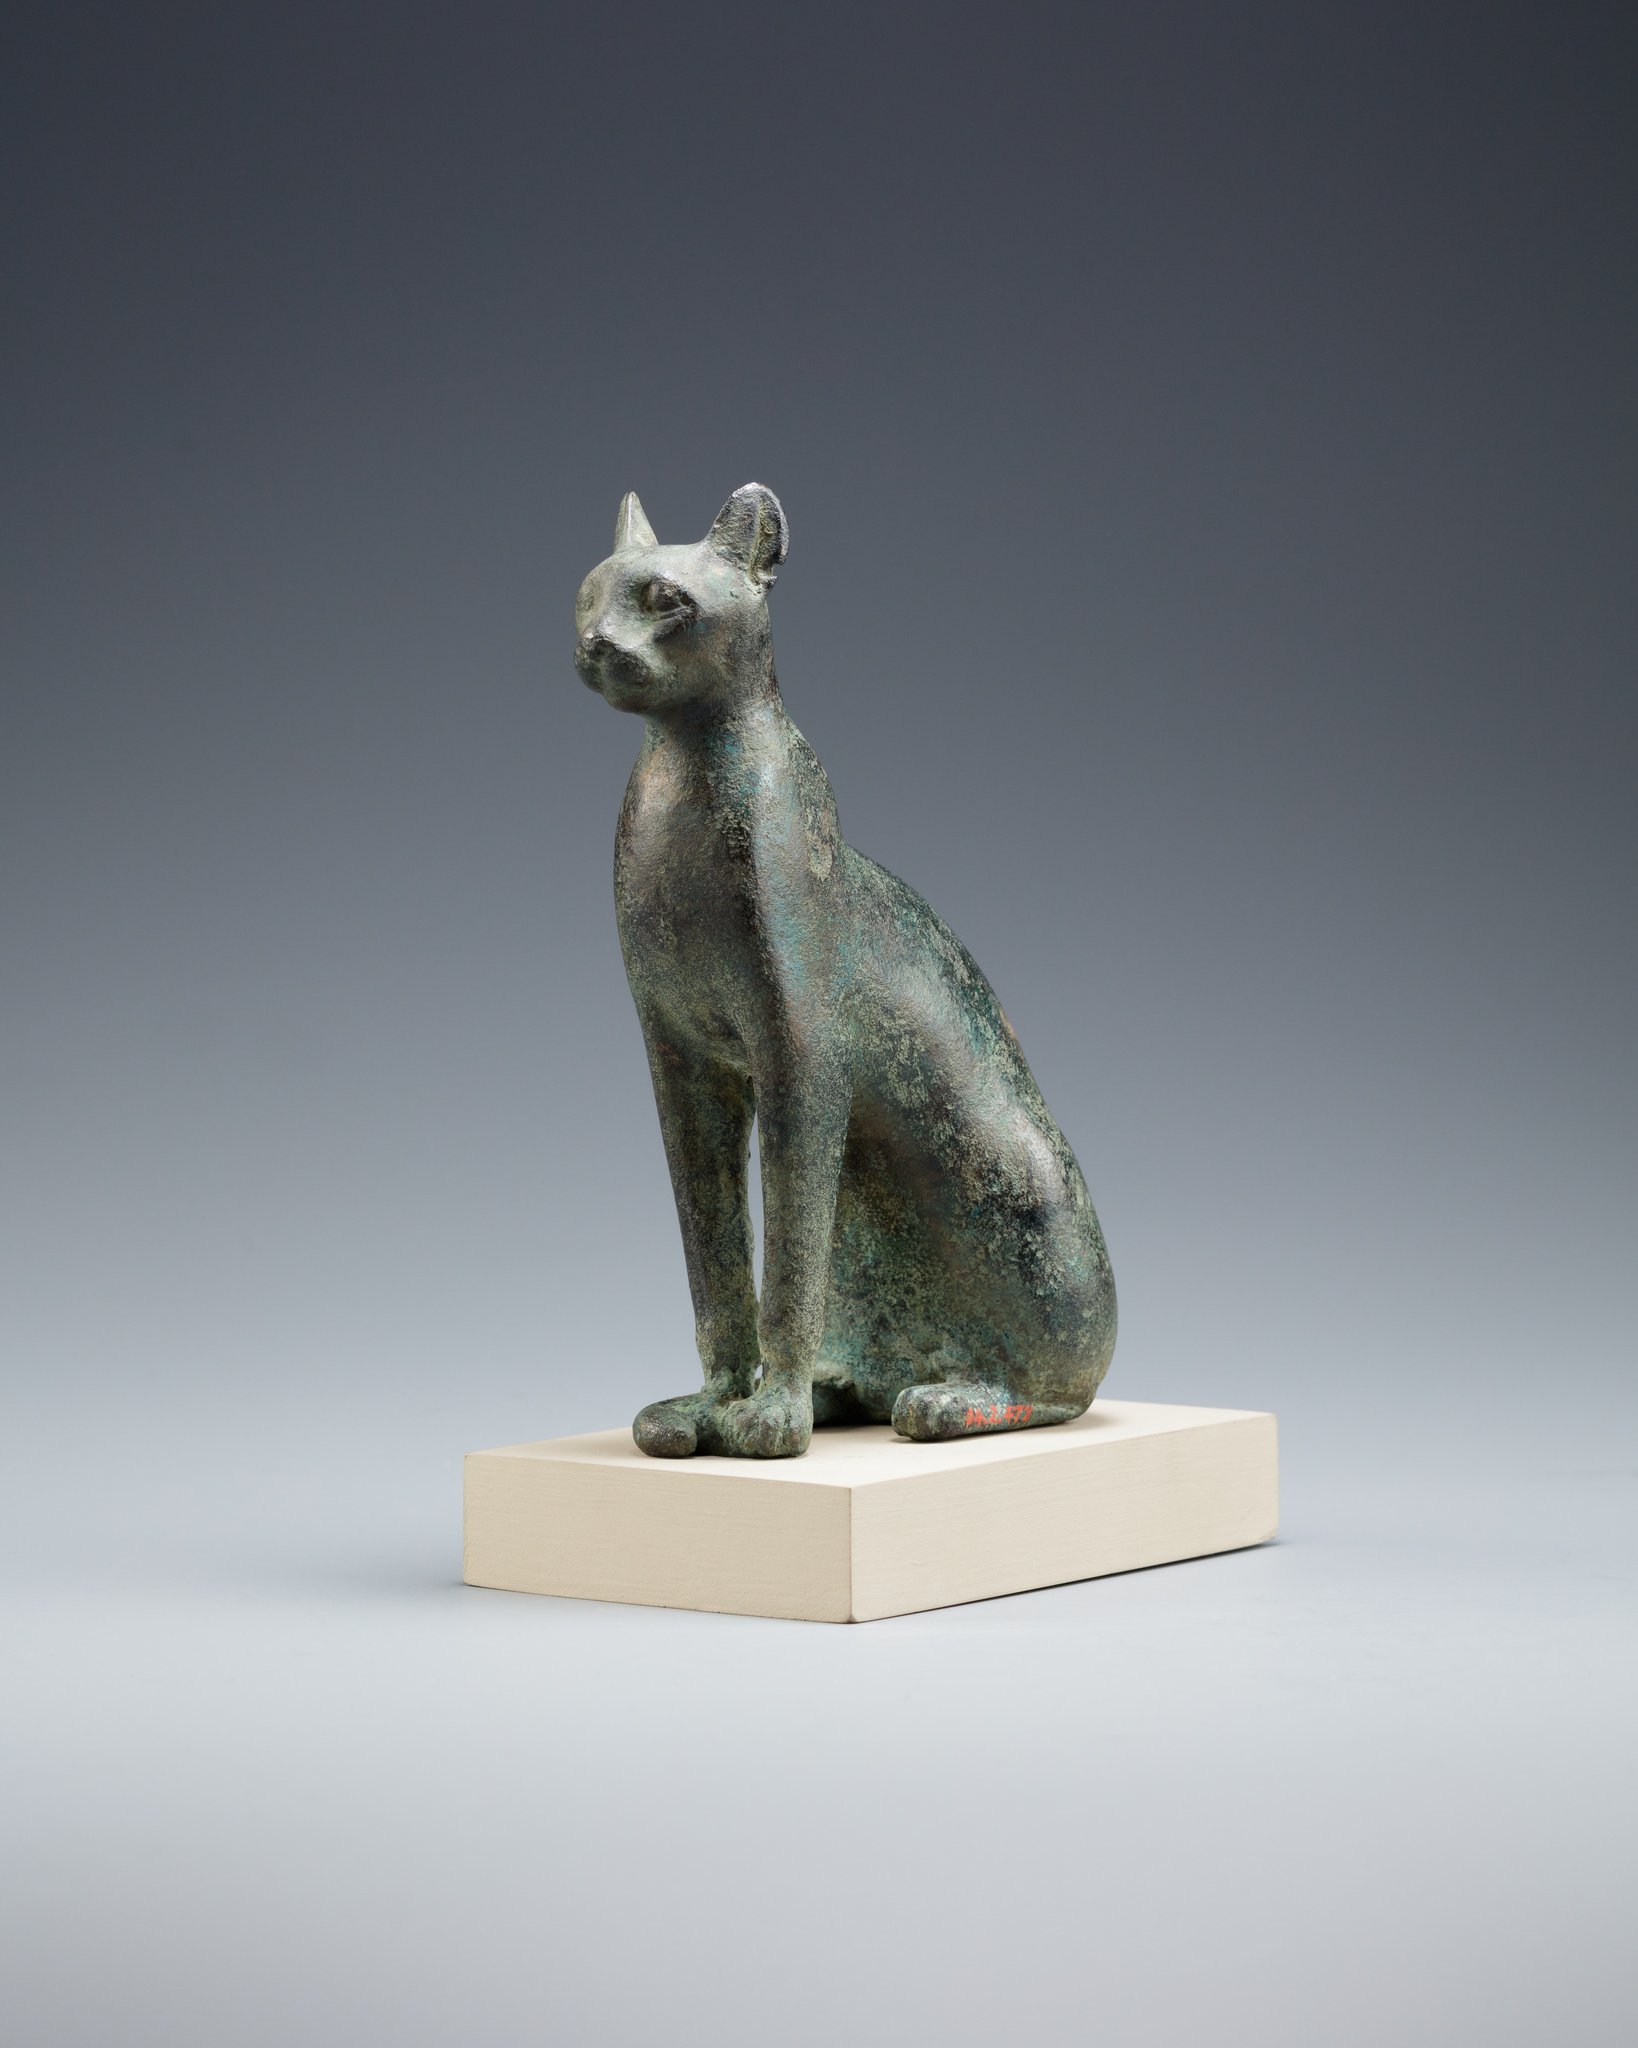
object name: figurine, cat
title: Cat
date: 664-630 BCE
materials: metal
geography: egypt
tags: cats